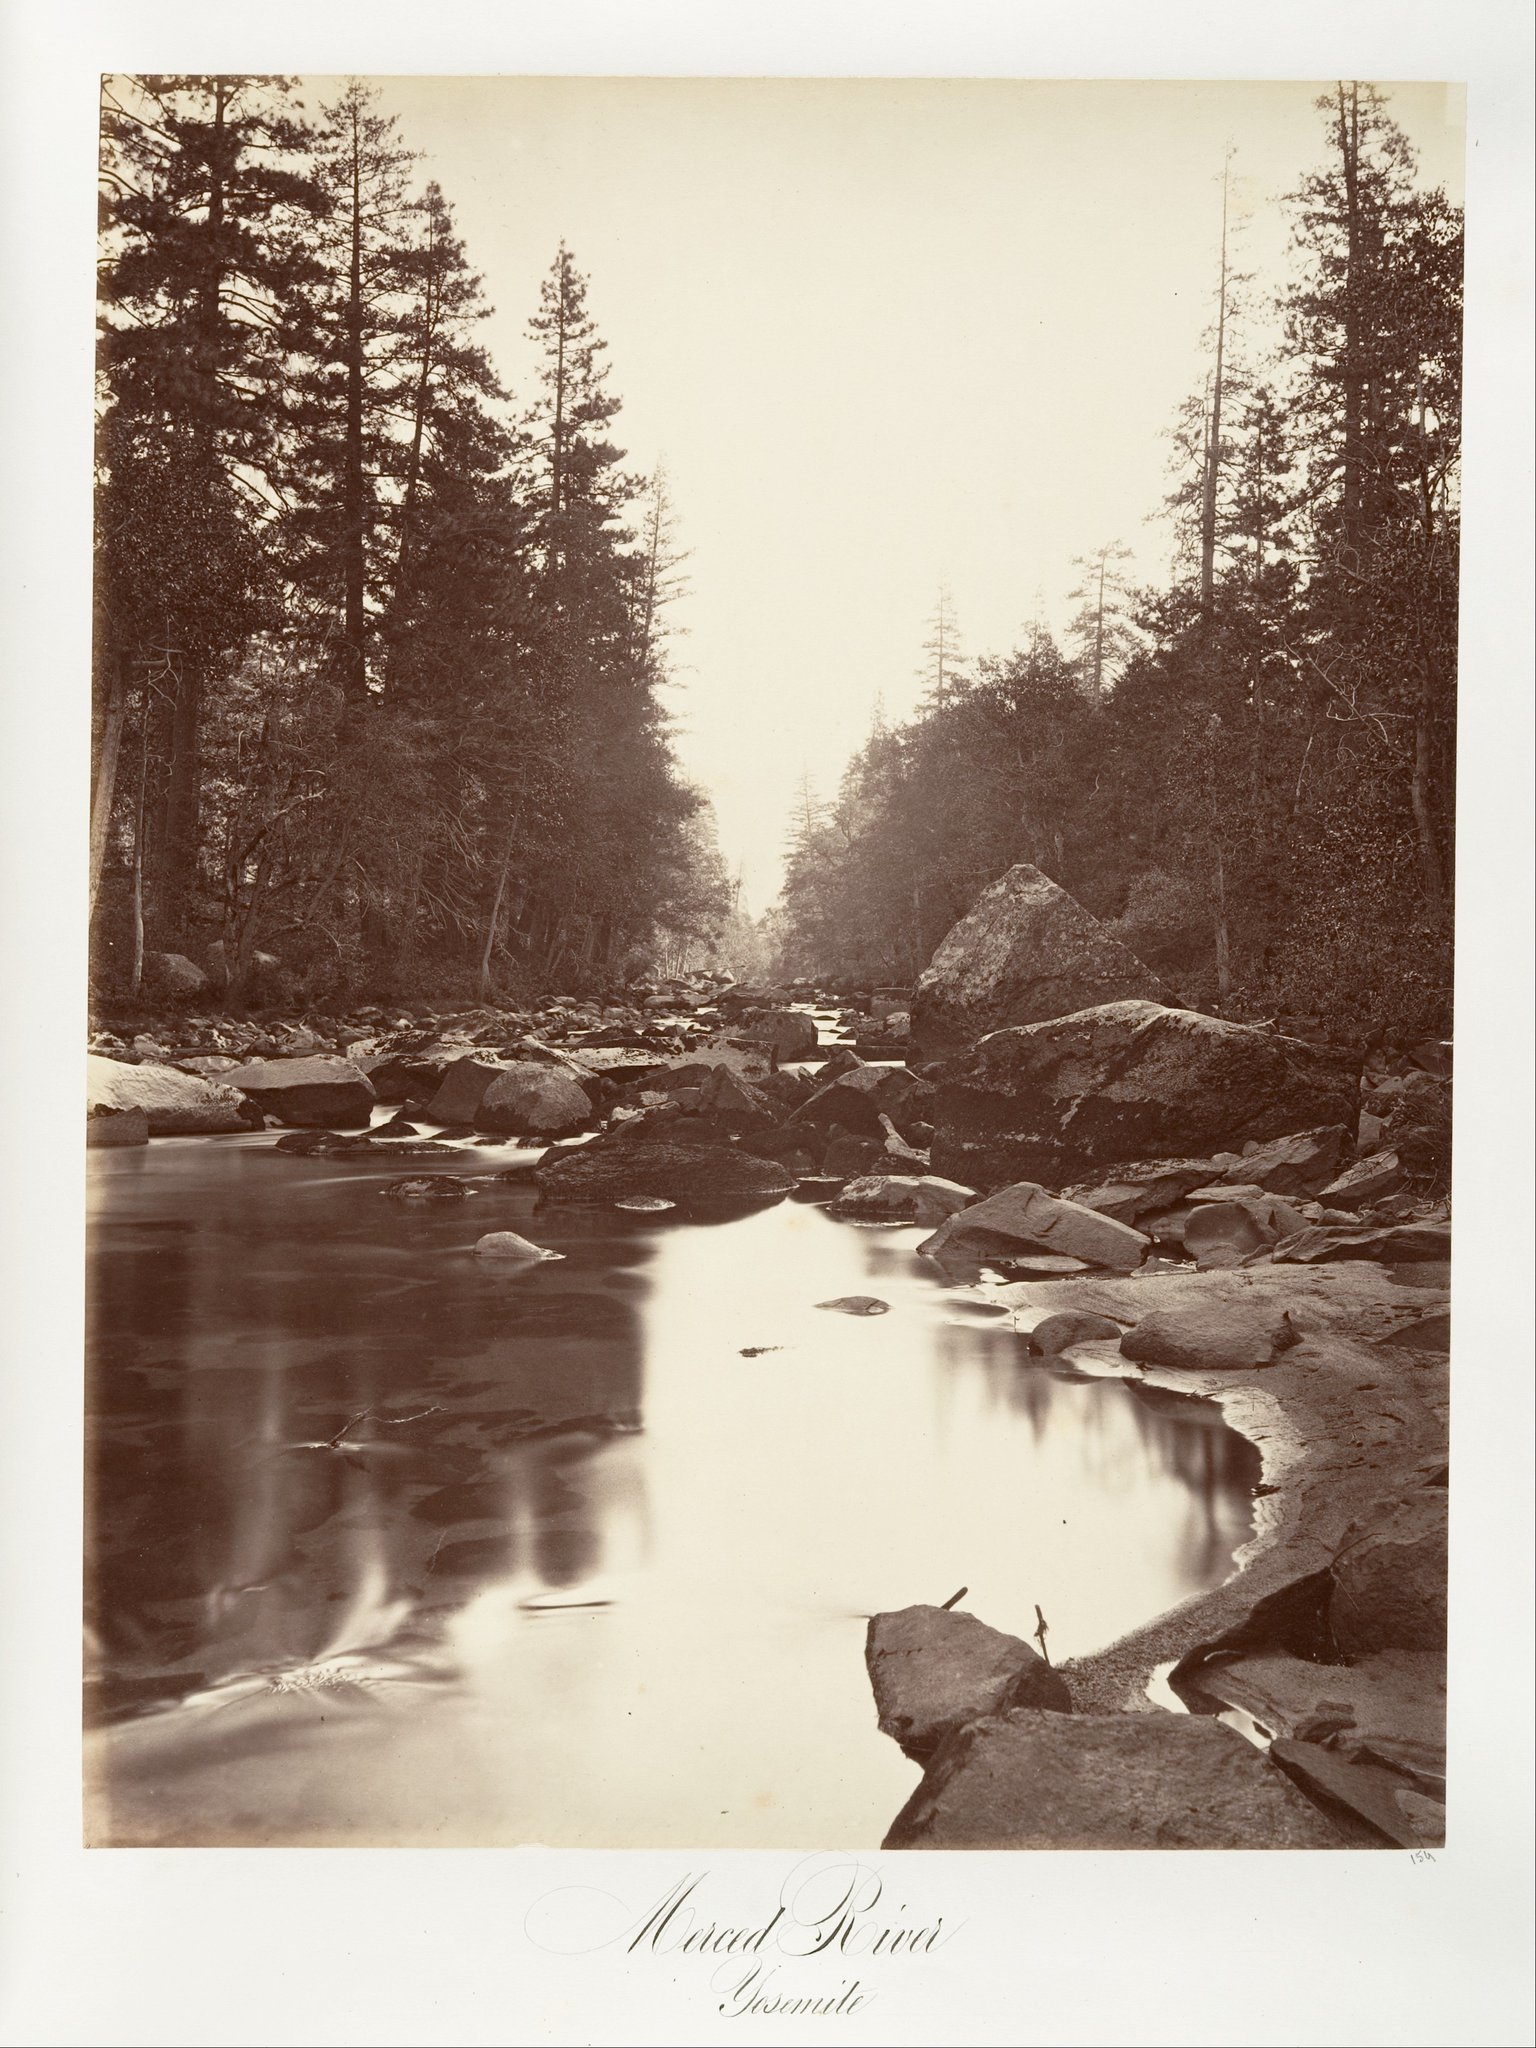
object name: photograph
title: Merced River, Yosemite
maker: carleton e. watkins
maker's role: artist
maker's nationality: american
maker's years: 1829-1916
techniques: albumen silver print, glass negative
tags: rivers,landscapes